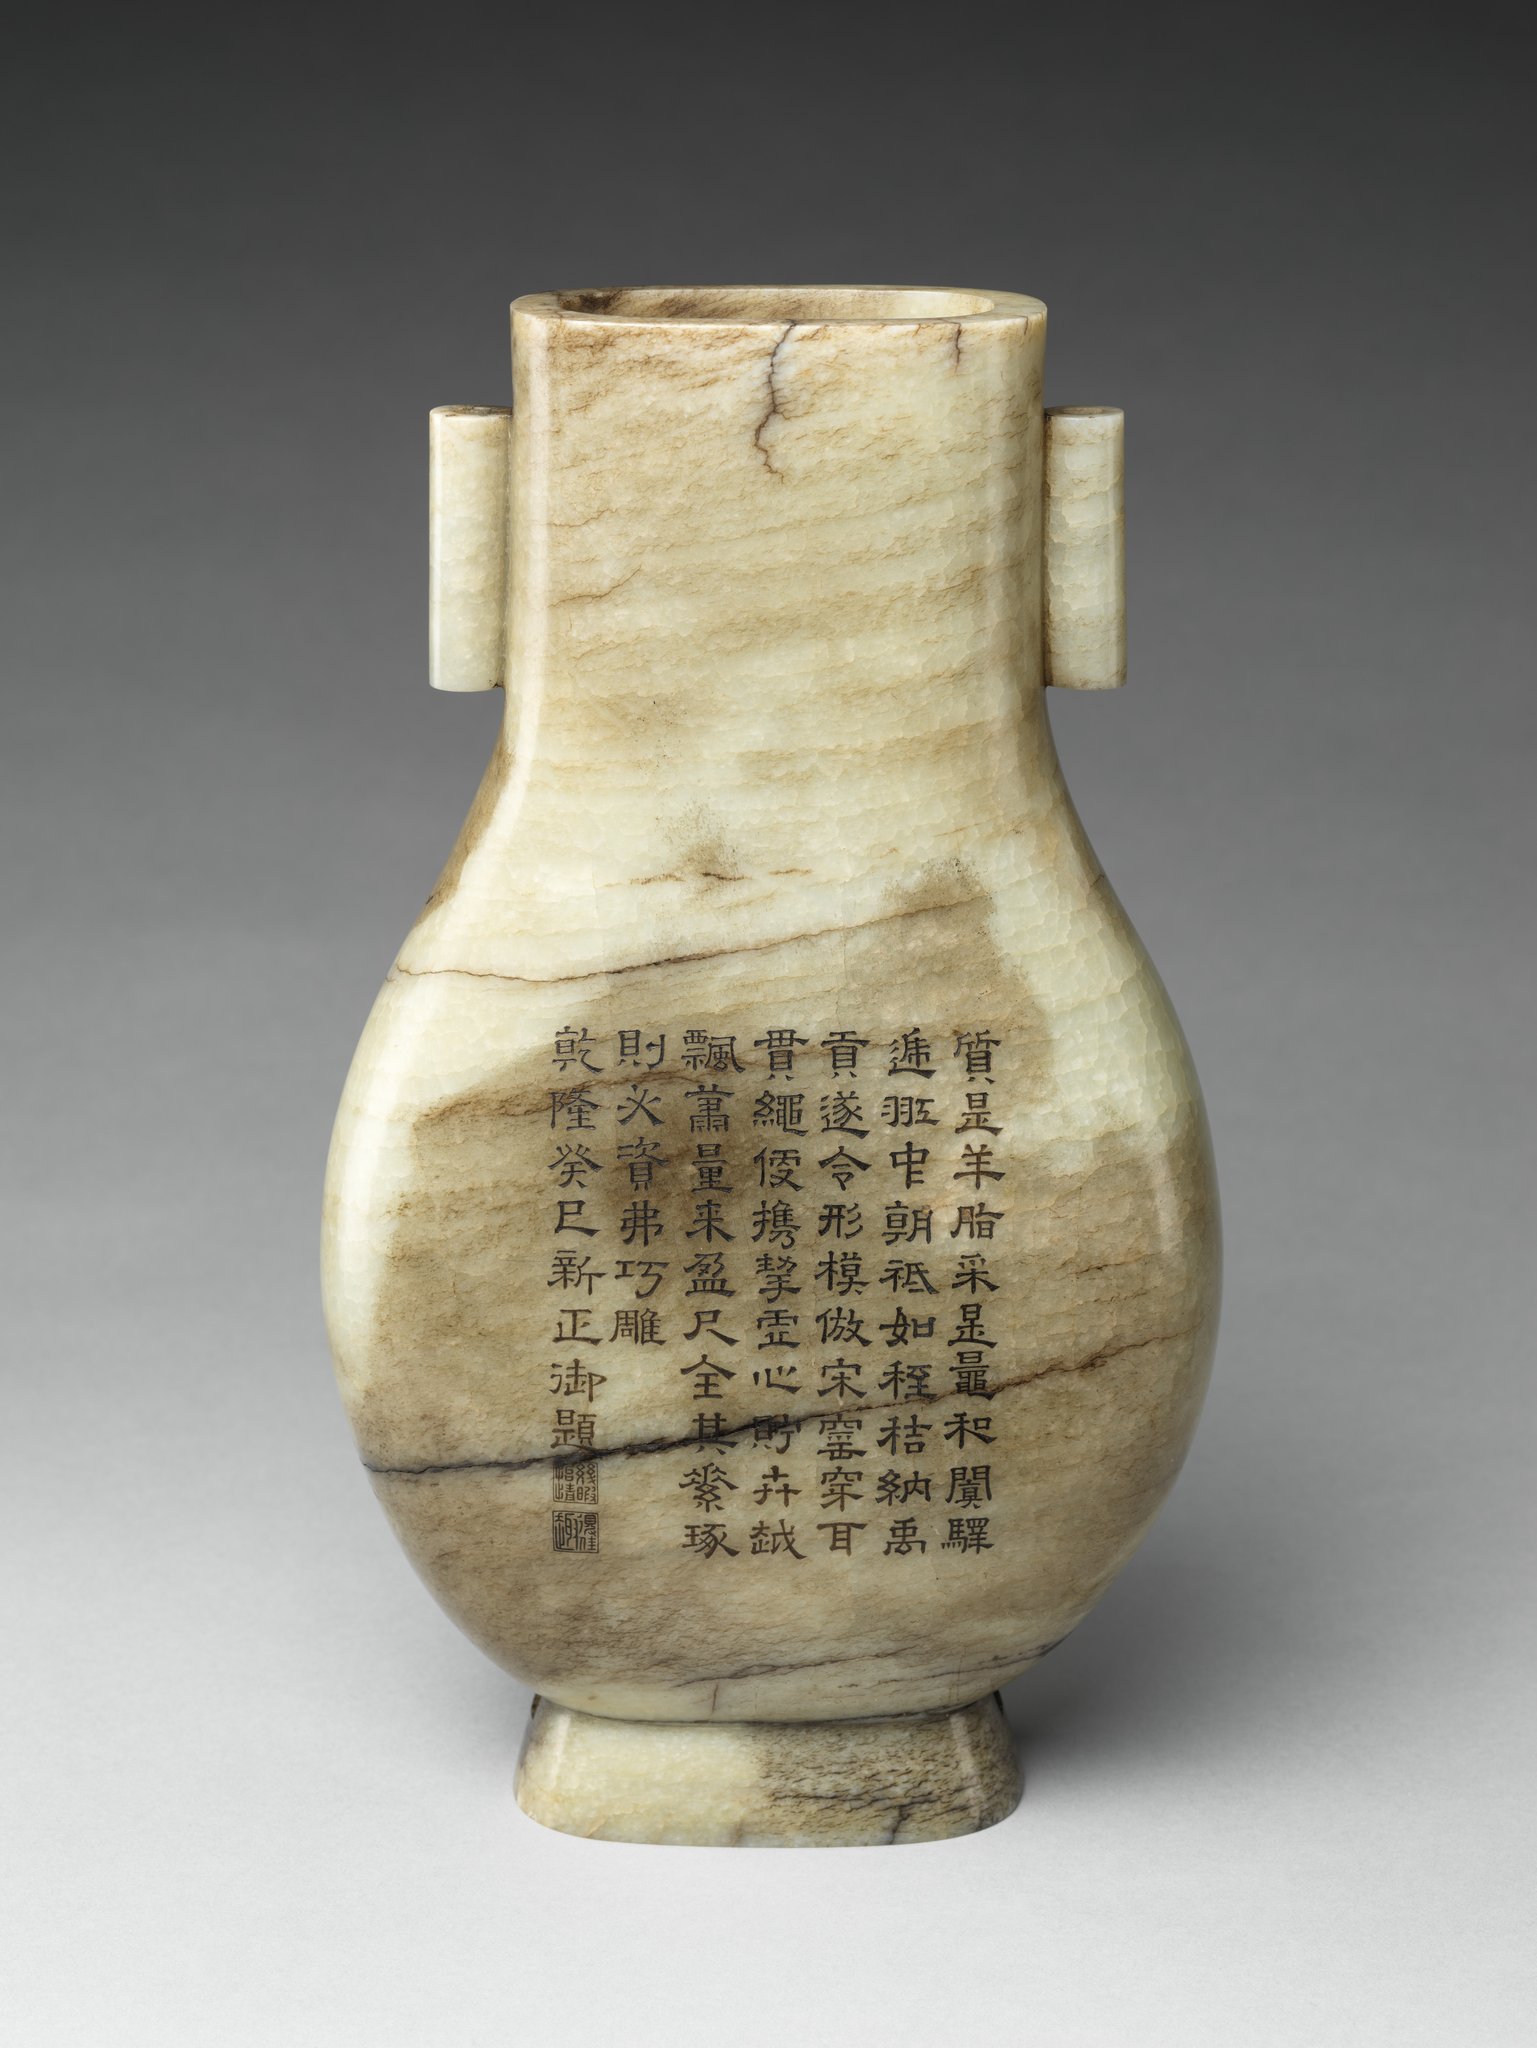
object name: vase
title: Archaic-style vase with poem composed by the Qianlong Emperor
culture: chinese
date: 1767-1800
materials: jade